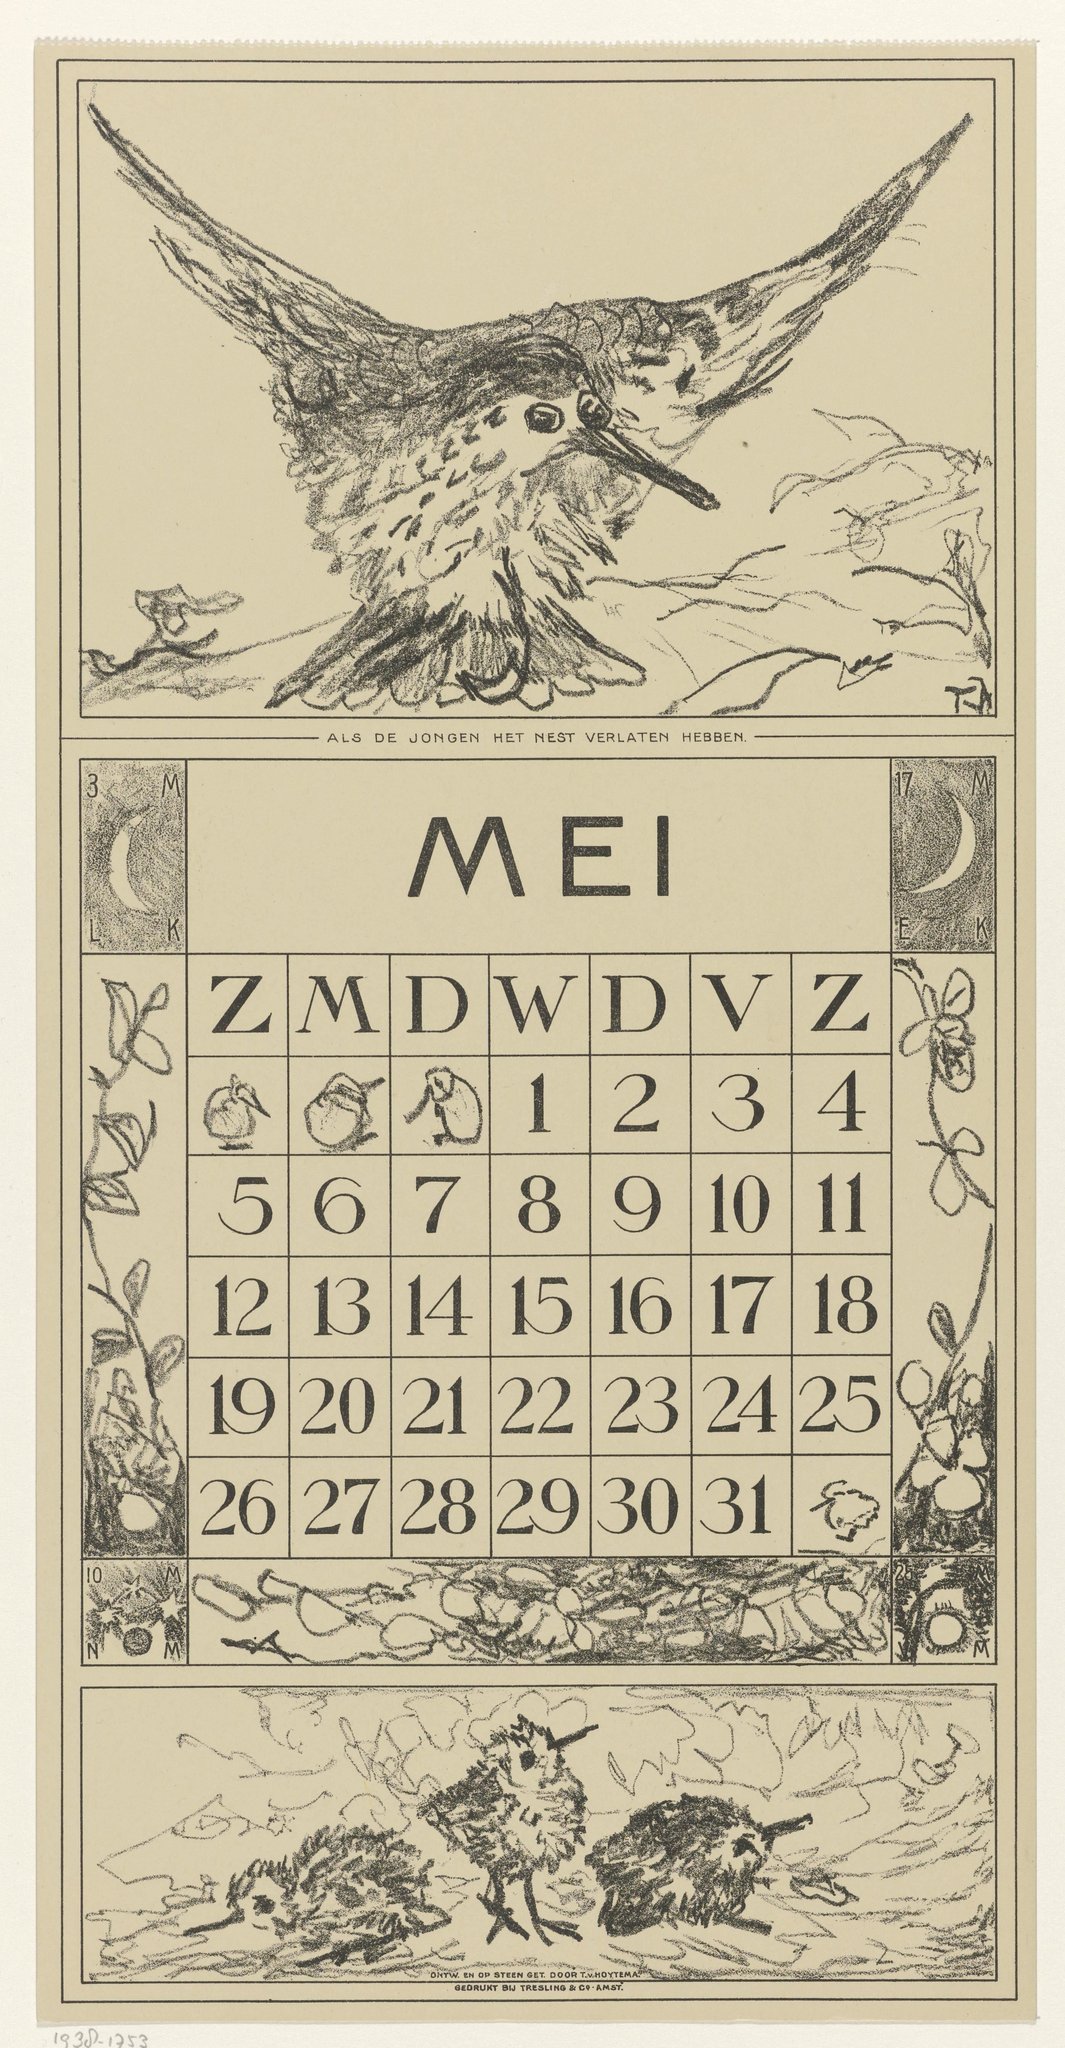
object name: print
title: Kalenderblad mei met vliegende vogel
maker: theo van hoytema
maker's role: draughtsman, painter, print maker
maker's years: 1863-1917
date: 1917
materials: paper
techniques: lithograph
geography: amsterdam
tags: birds, birds (+ feeding and care of young), lunar year, may ~ other concepts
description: Bovenin een vliegende vogel, onderin drie jonge vogels. In de hoeken de standen van de maan op vier dagen. Bovenaan het blad een scheurlijn.